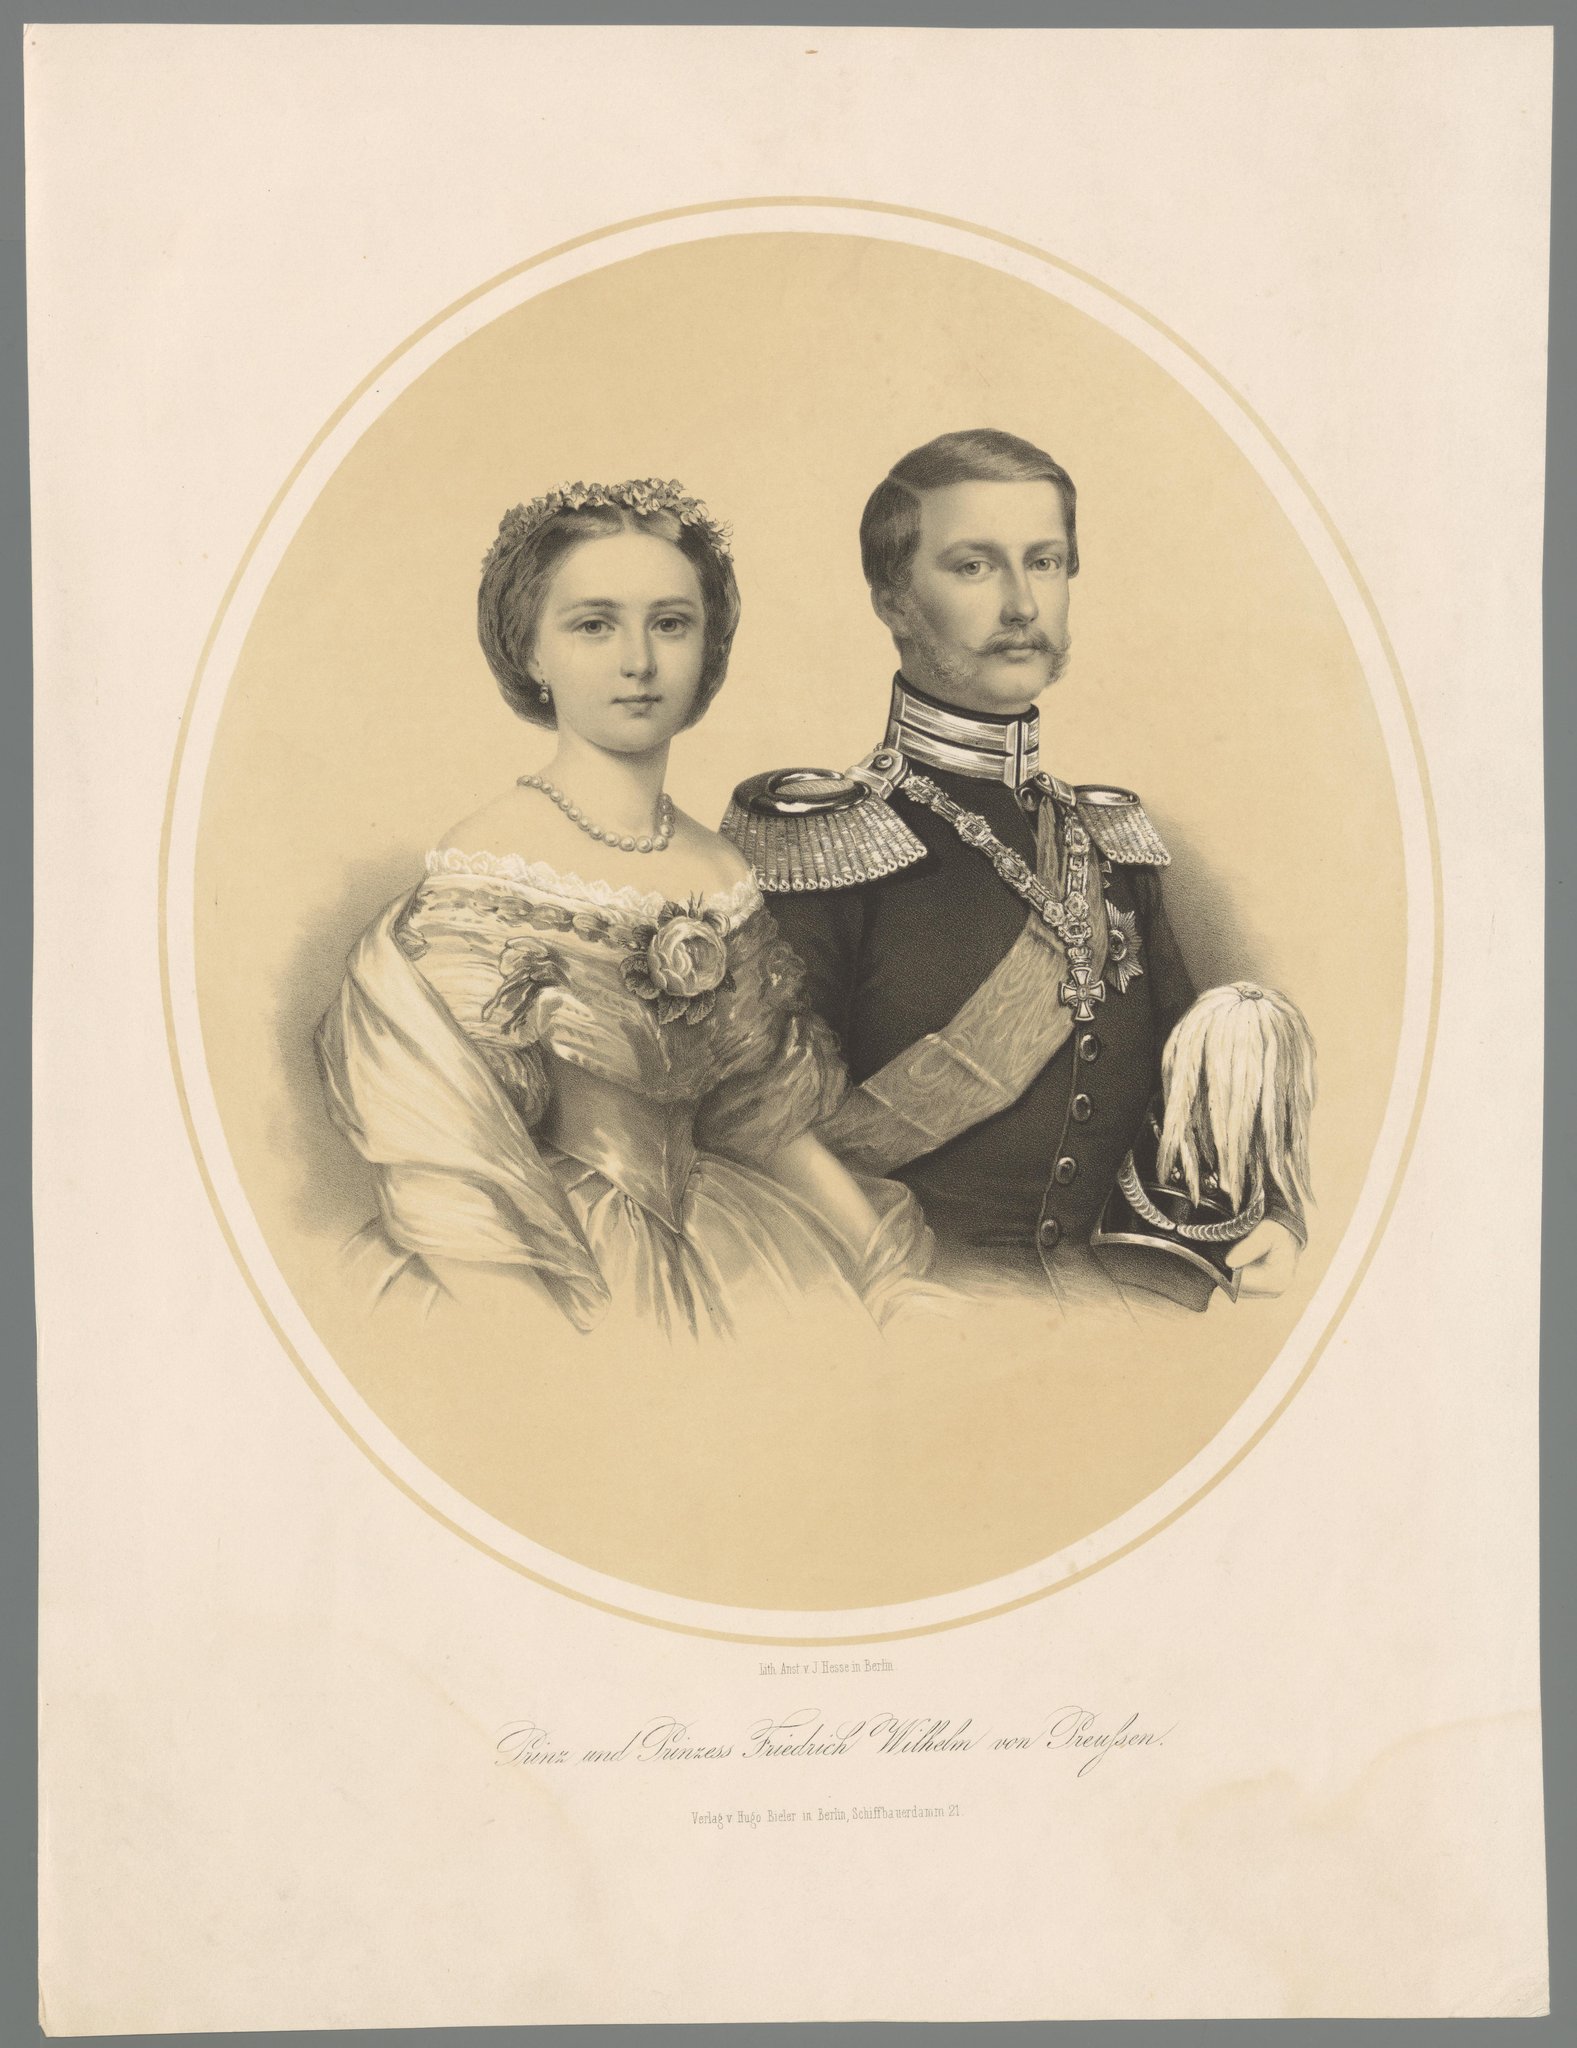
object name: print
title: Portret van Frederik Willem IV en Elisabeth Ludovika van Beieren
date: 1823-1840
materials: paper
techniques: tone lithography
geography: berlin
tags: berlin, frederik willem iv (koning van pruisen), historical persons, ruler, sovereign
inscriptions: collector's mark: Lugt 2228